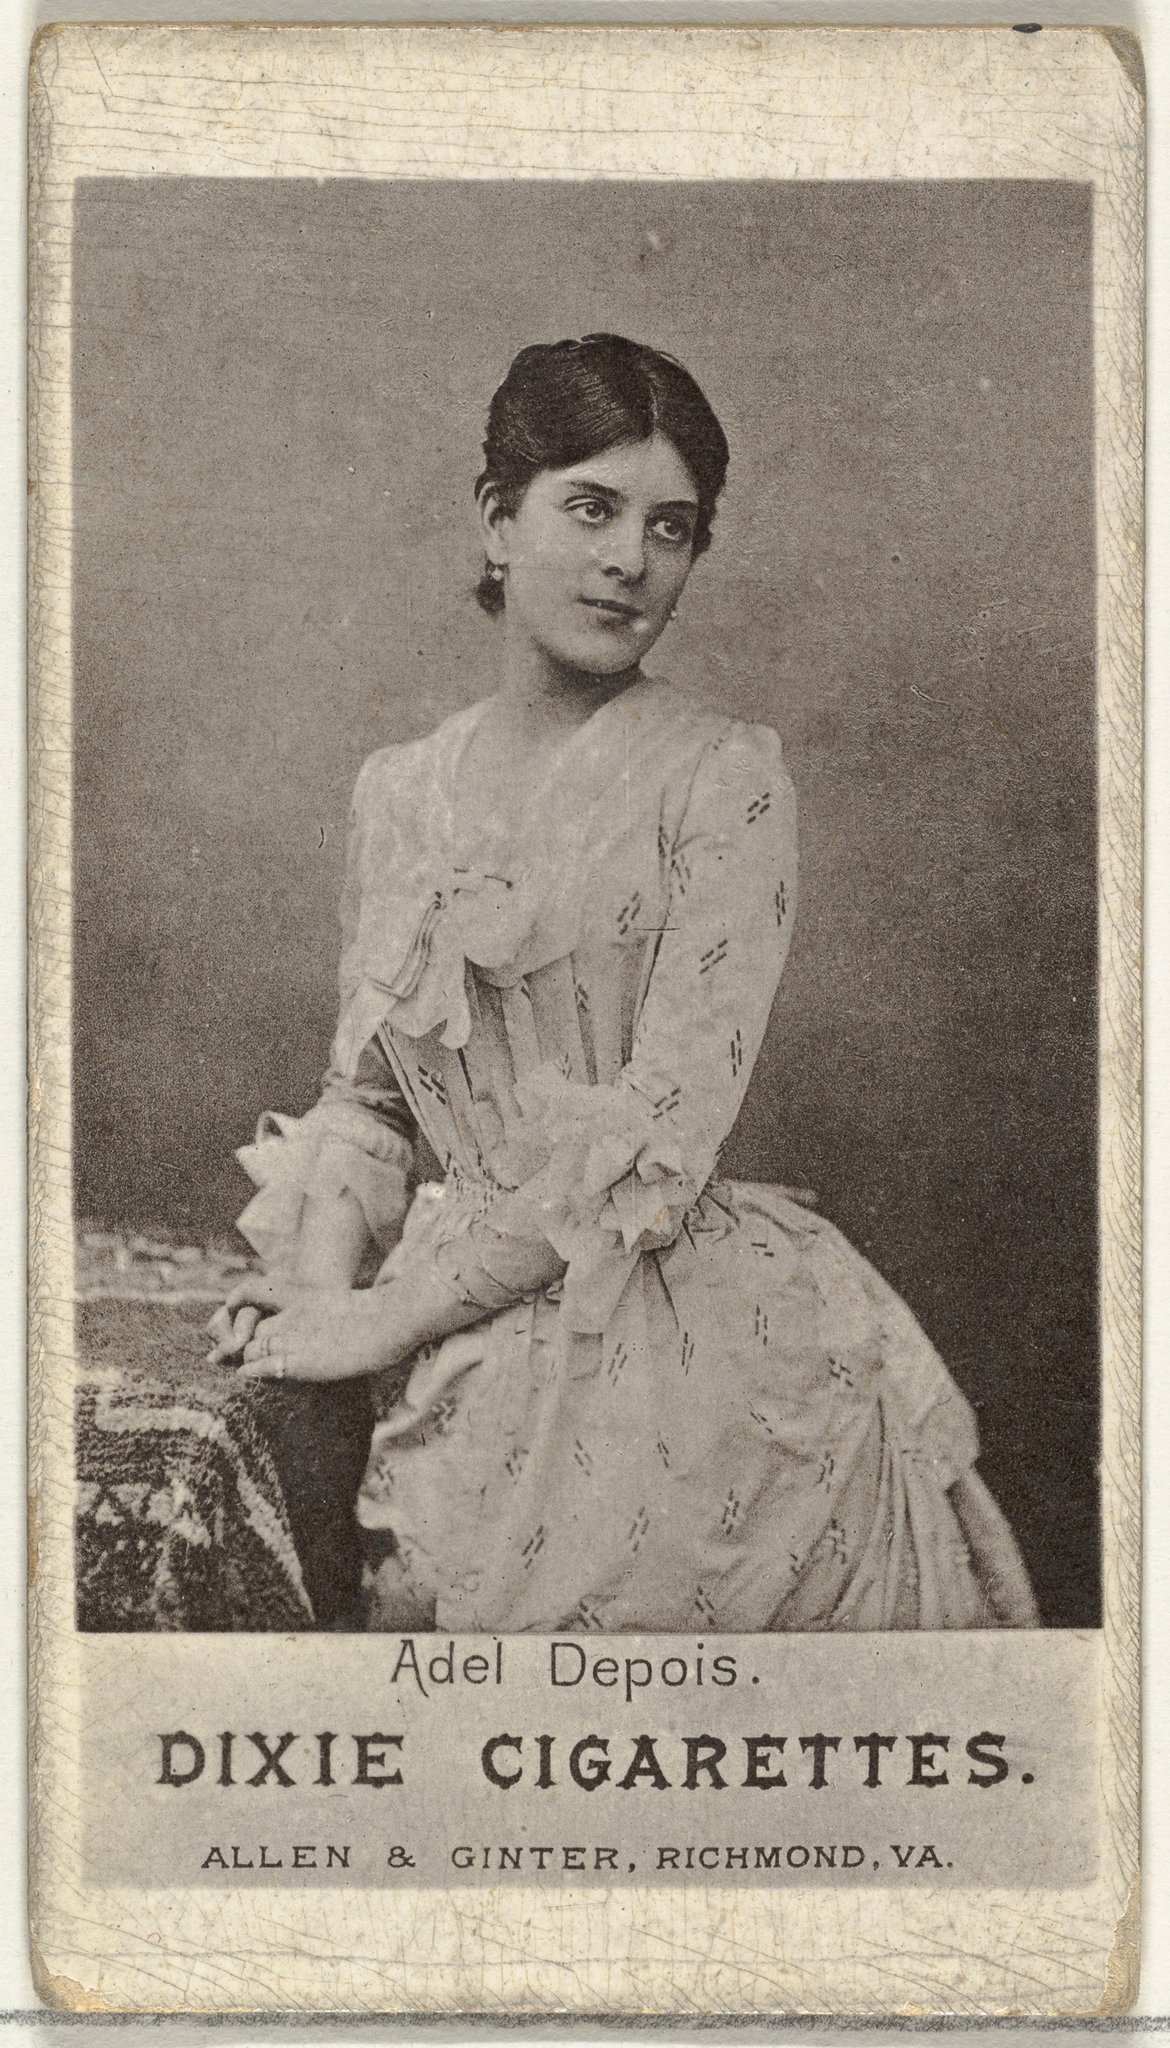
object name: print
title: Adel Depois, from the Actresses series (N67) promoting Dixie Cigarettes for Allen & Ginter brand tobacco products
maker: allen & ginter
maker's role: publisher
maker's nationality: american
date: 1888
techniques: photolithograph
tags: portraits,women,actresses